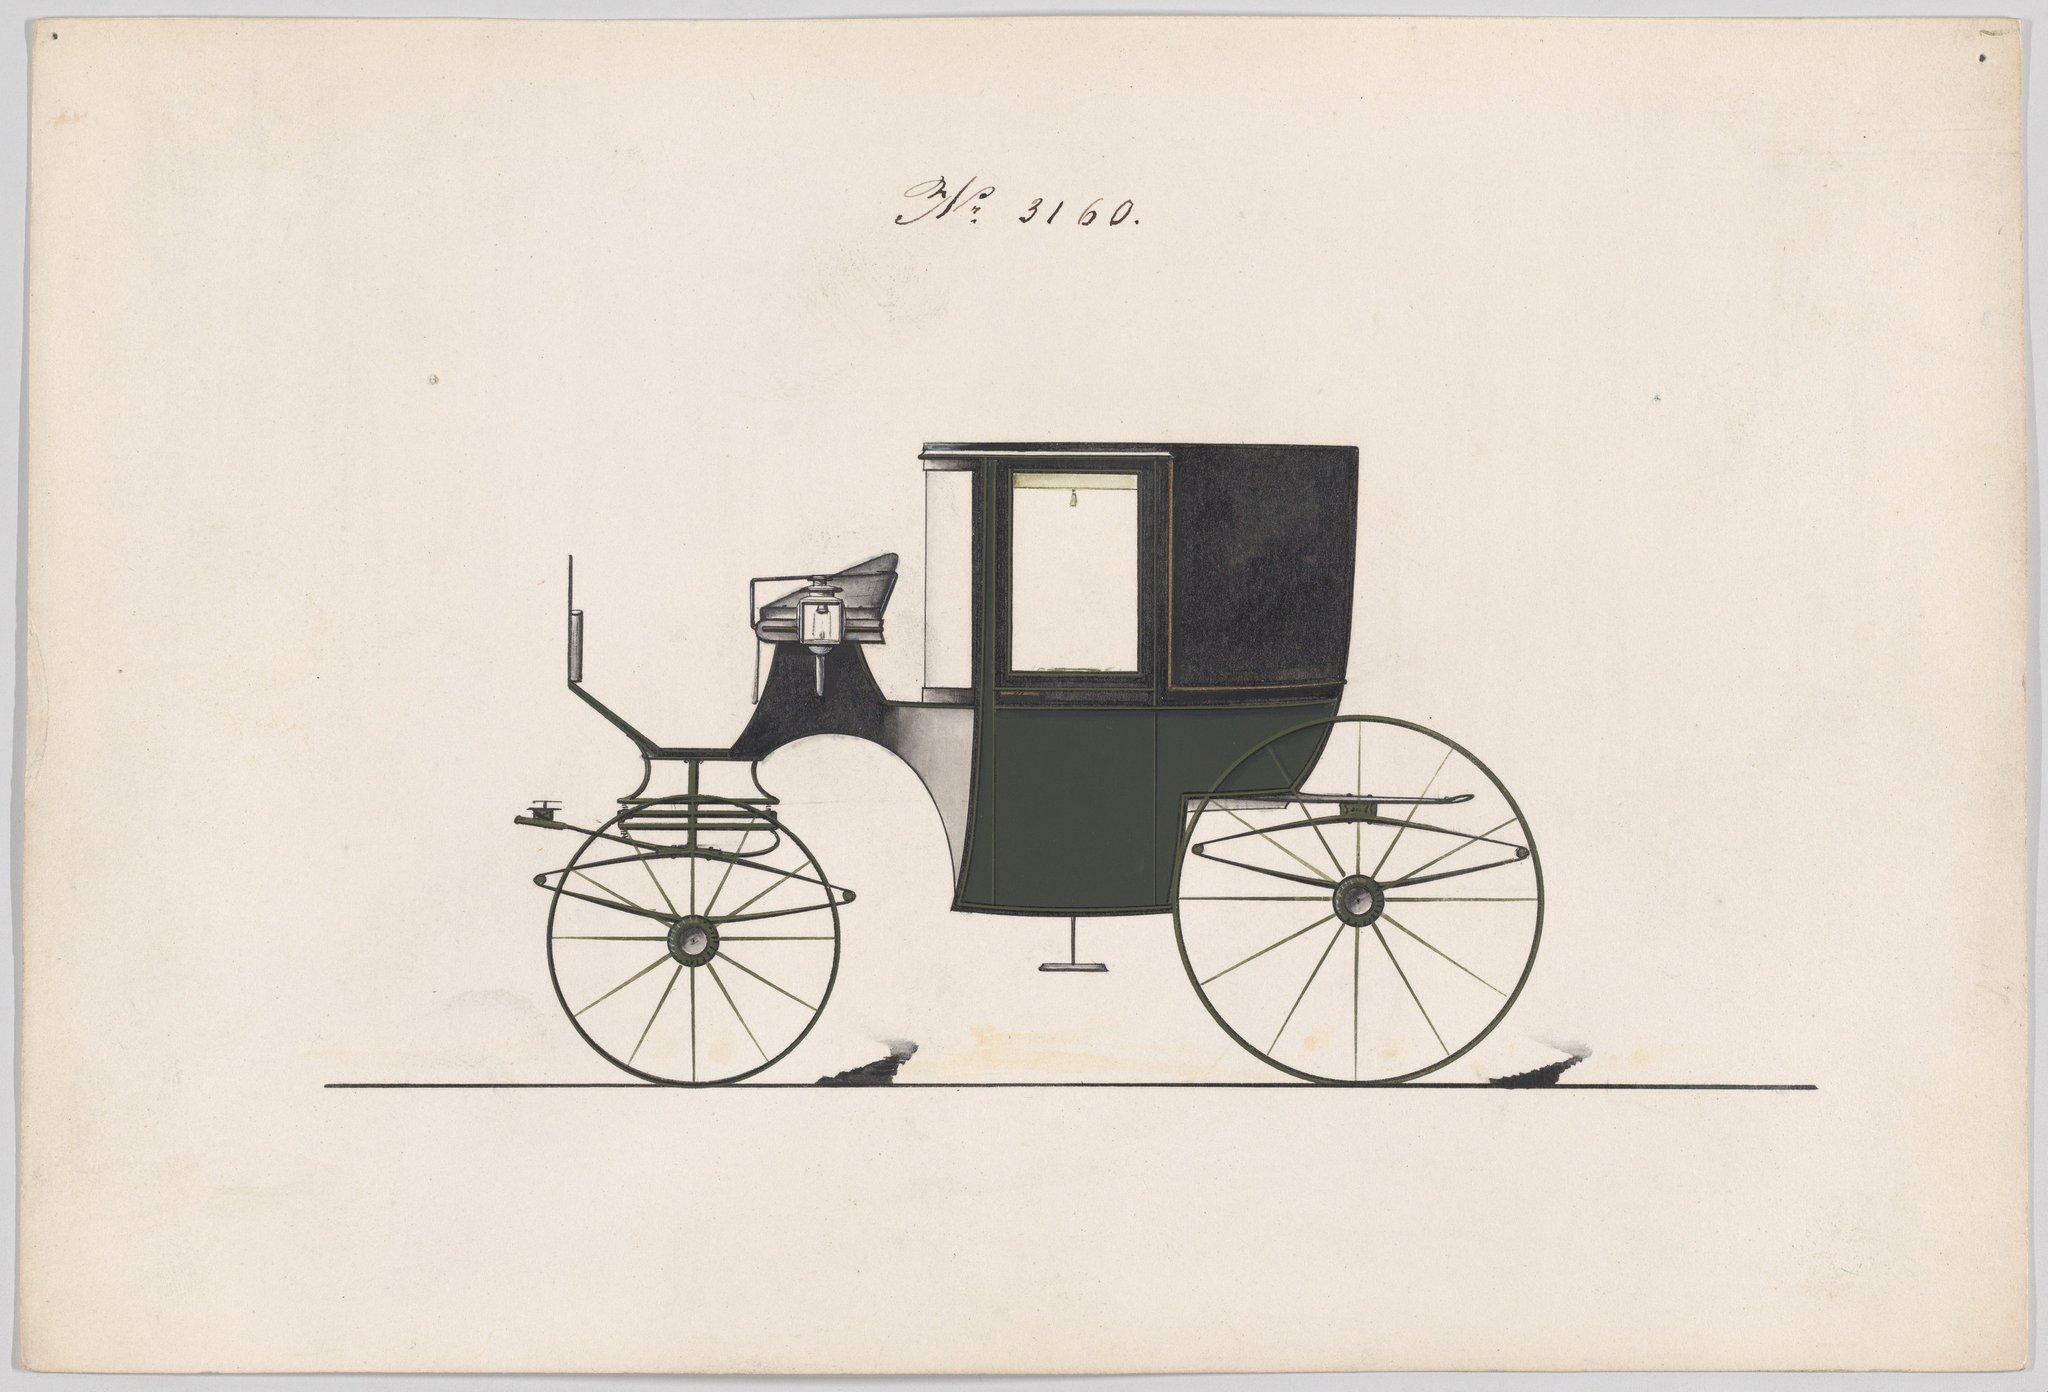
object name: drawing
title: Design for Coupé, no. 3160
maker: brewster & co.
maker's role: manufacturer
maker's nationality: american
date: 1875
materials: gouache, ink, watercolor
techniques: pen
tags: carriages